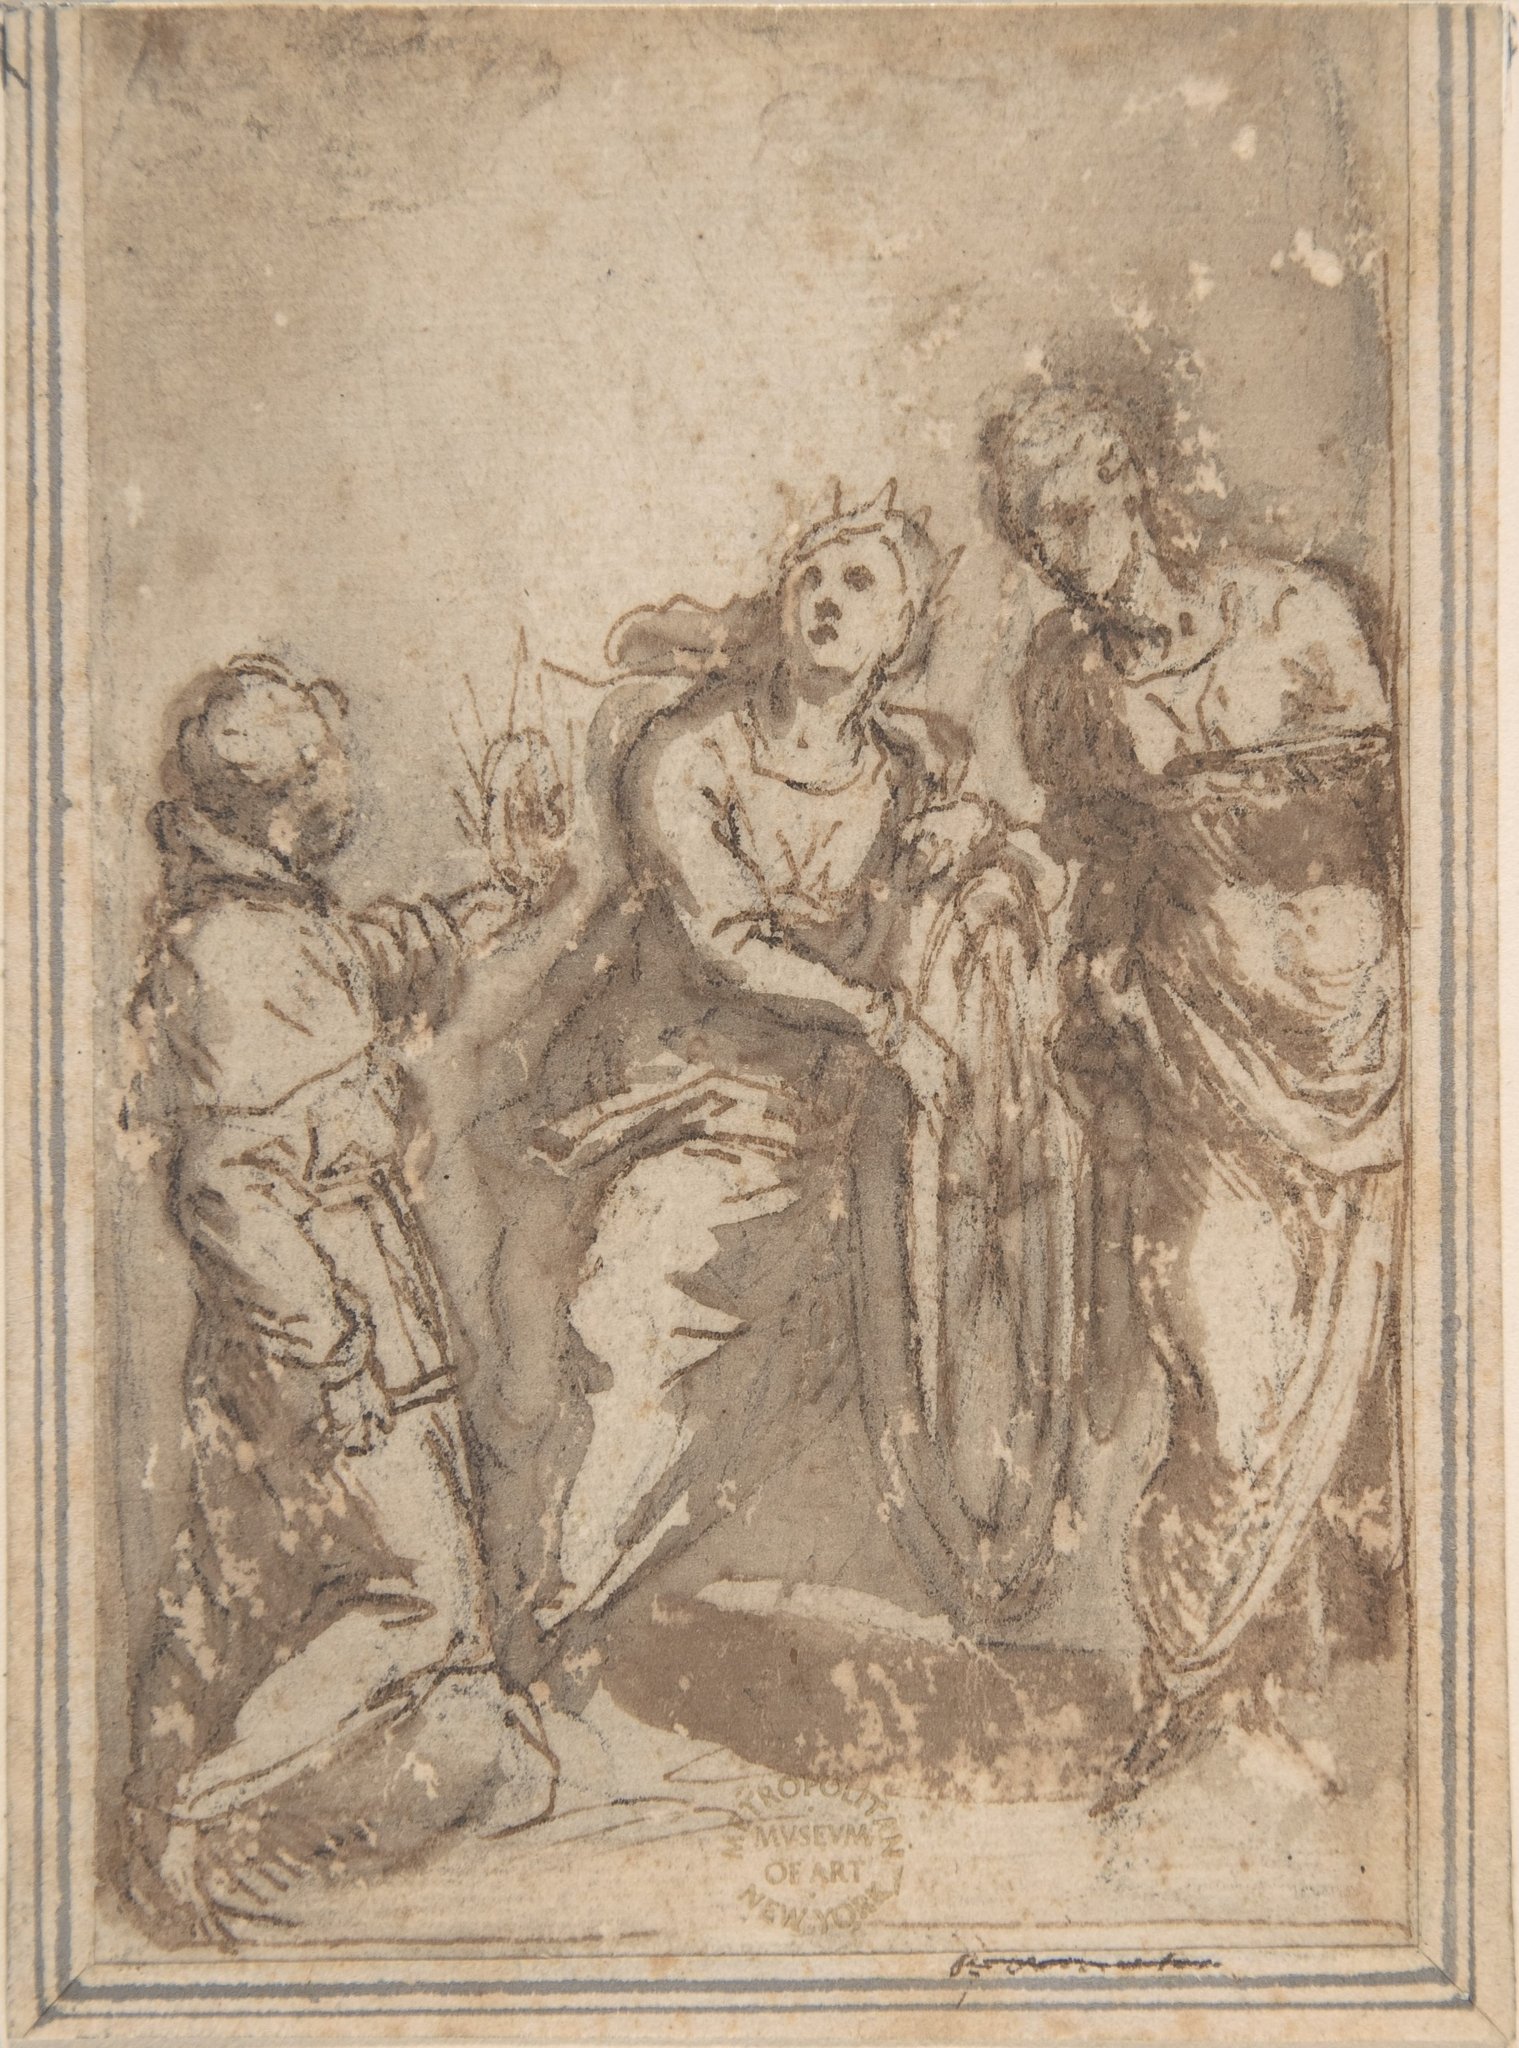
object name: drawing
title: Saint Catherine Flanked by a Male and a Female Saint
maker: anonymous, italian, bolognese, 17th century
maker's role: artist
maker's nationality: italian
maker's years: 1600-1700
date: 1601-1700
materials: chalk, ink, paper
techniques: brush, pen, wash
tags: saint catherine,saints